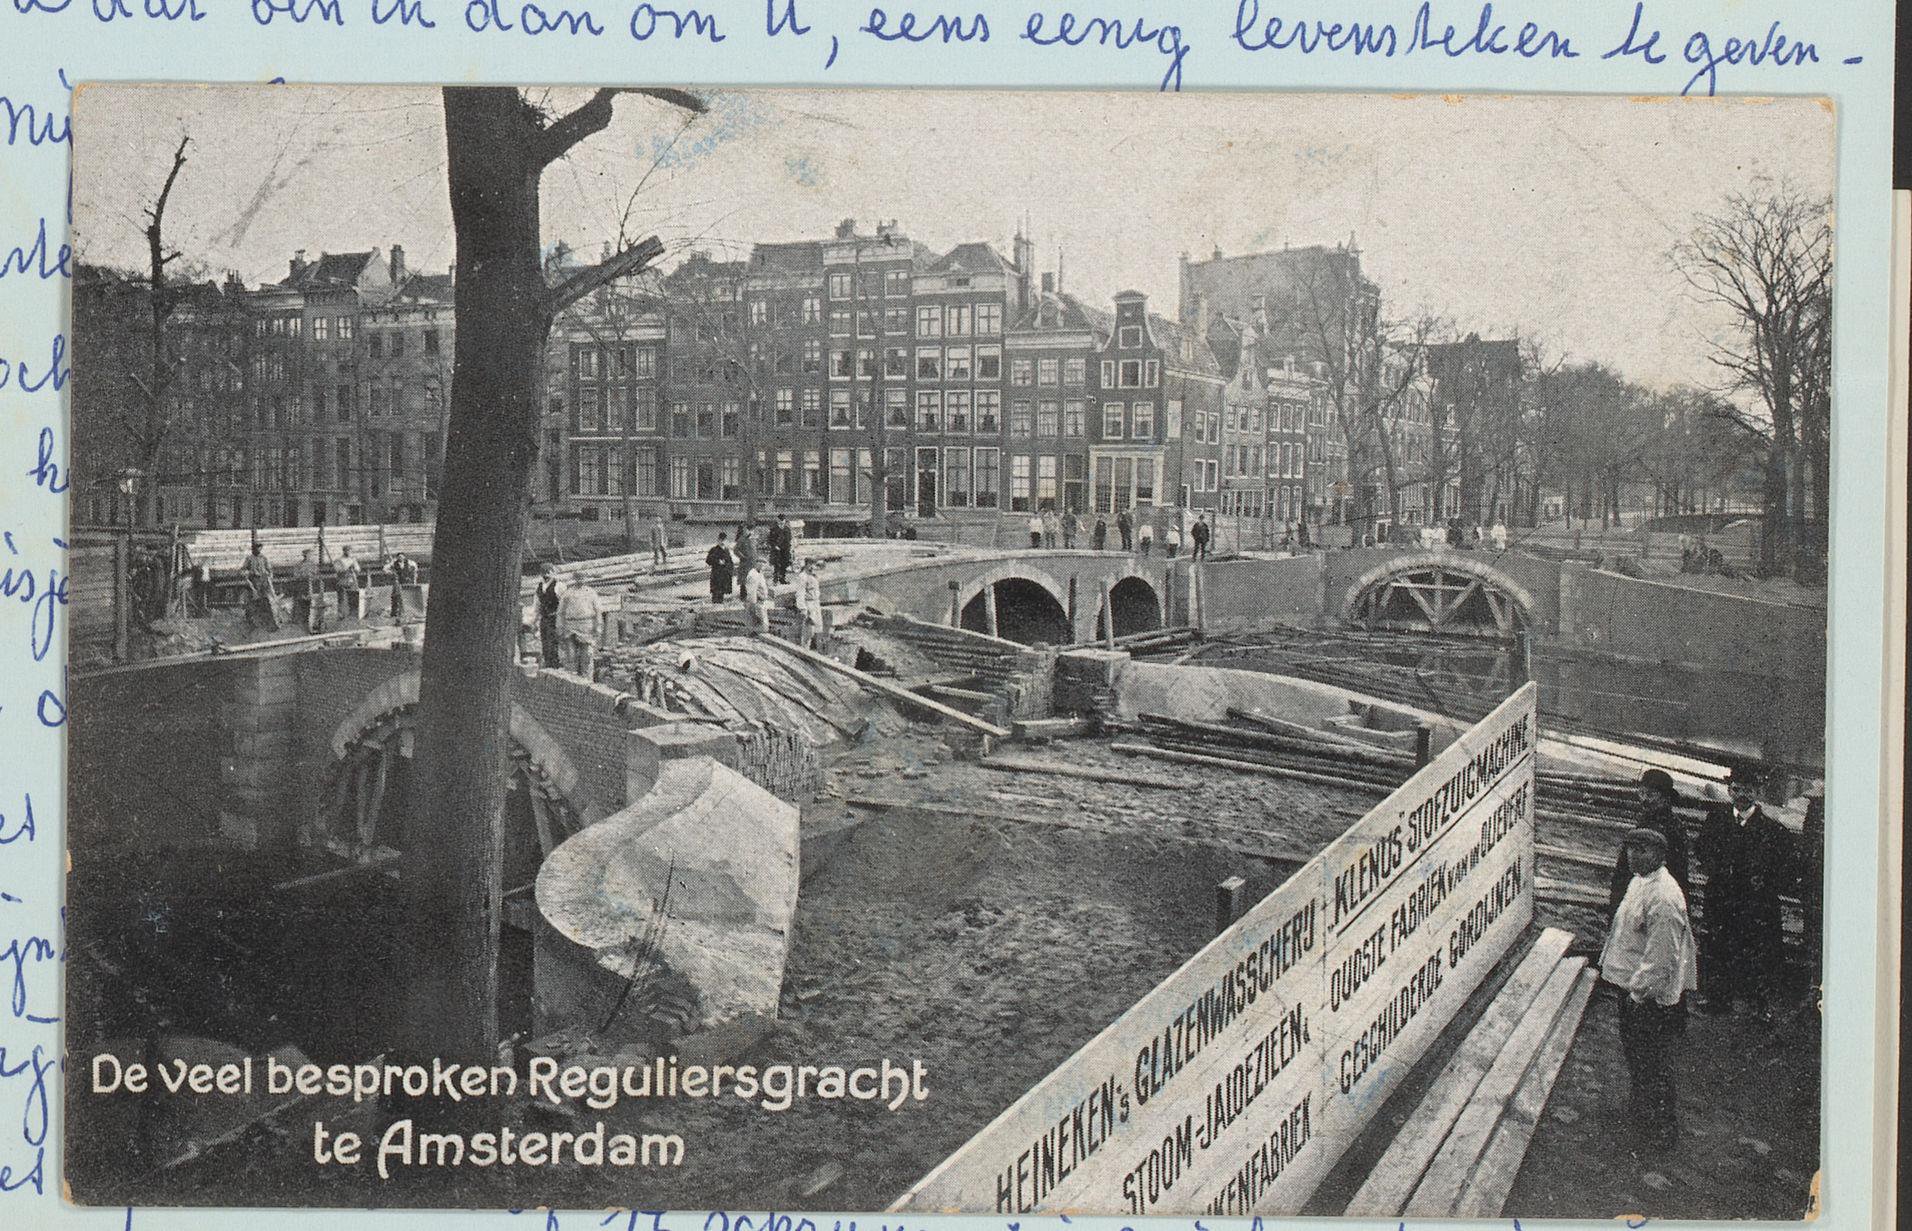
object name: ansichtkaart, prentbriefkaart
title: De veel besproken Reguliersgracht te Amsterdam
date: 1945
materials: paper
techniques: printing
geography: amsterdam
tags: building-site, bridge in city across river, canal, etc.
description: Kaart met een foto van de reparatiewerk aan de bruggen bij de Reguliersgracht. Met geschreven tekst van de huishoudster Anna aan de heer Norbert van den Berg, gedateerd 30 december 1945. Los object behorend bij albumblad nr. 12 in het fotoalbum over de bewoners van het huis aan de Reguliersgracht te Amsterdam in de periode 1924-1932.